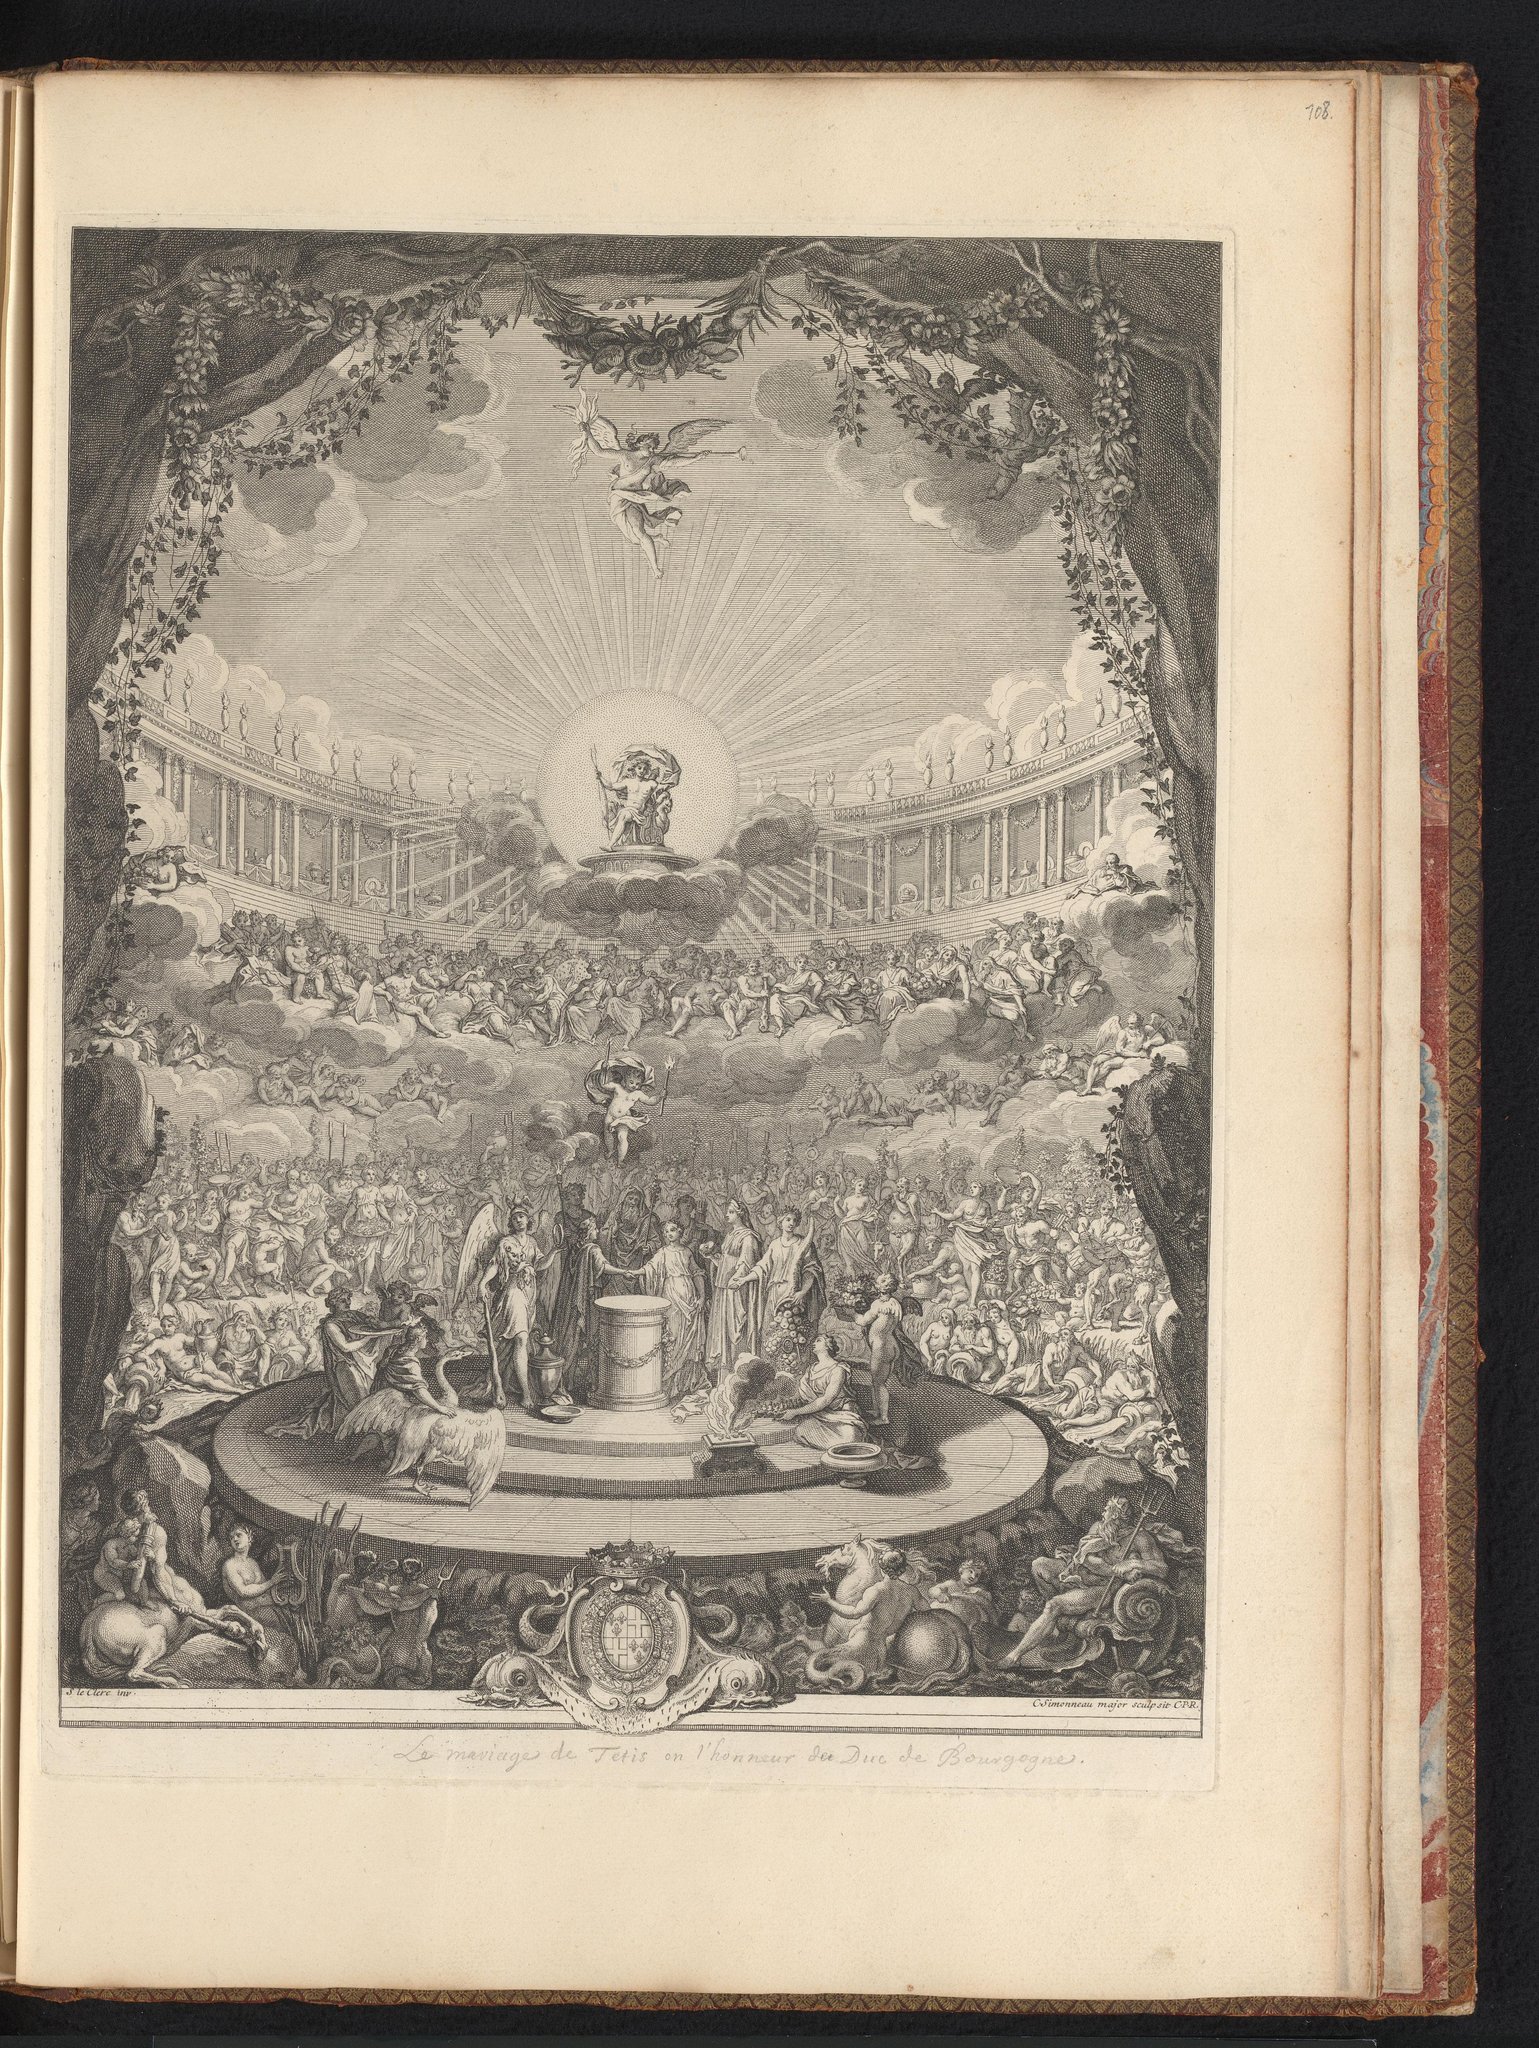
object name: print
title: Allegorie op de bruiloft van Lodewijk van Bourgondië en Maria Adelheid van Savoye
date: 1697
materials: paper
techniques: etching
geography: paris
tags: lodewijk van frankrijk (hertog van bourgondië), historical persons, (civil) marriage ceremonies, gods ~ classical mythology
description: Deze prent maakt deel uit van een album.